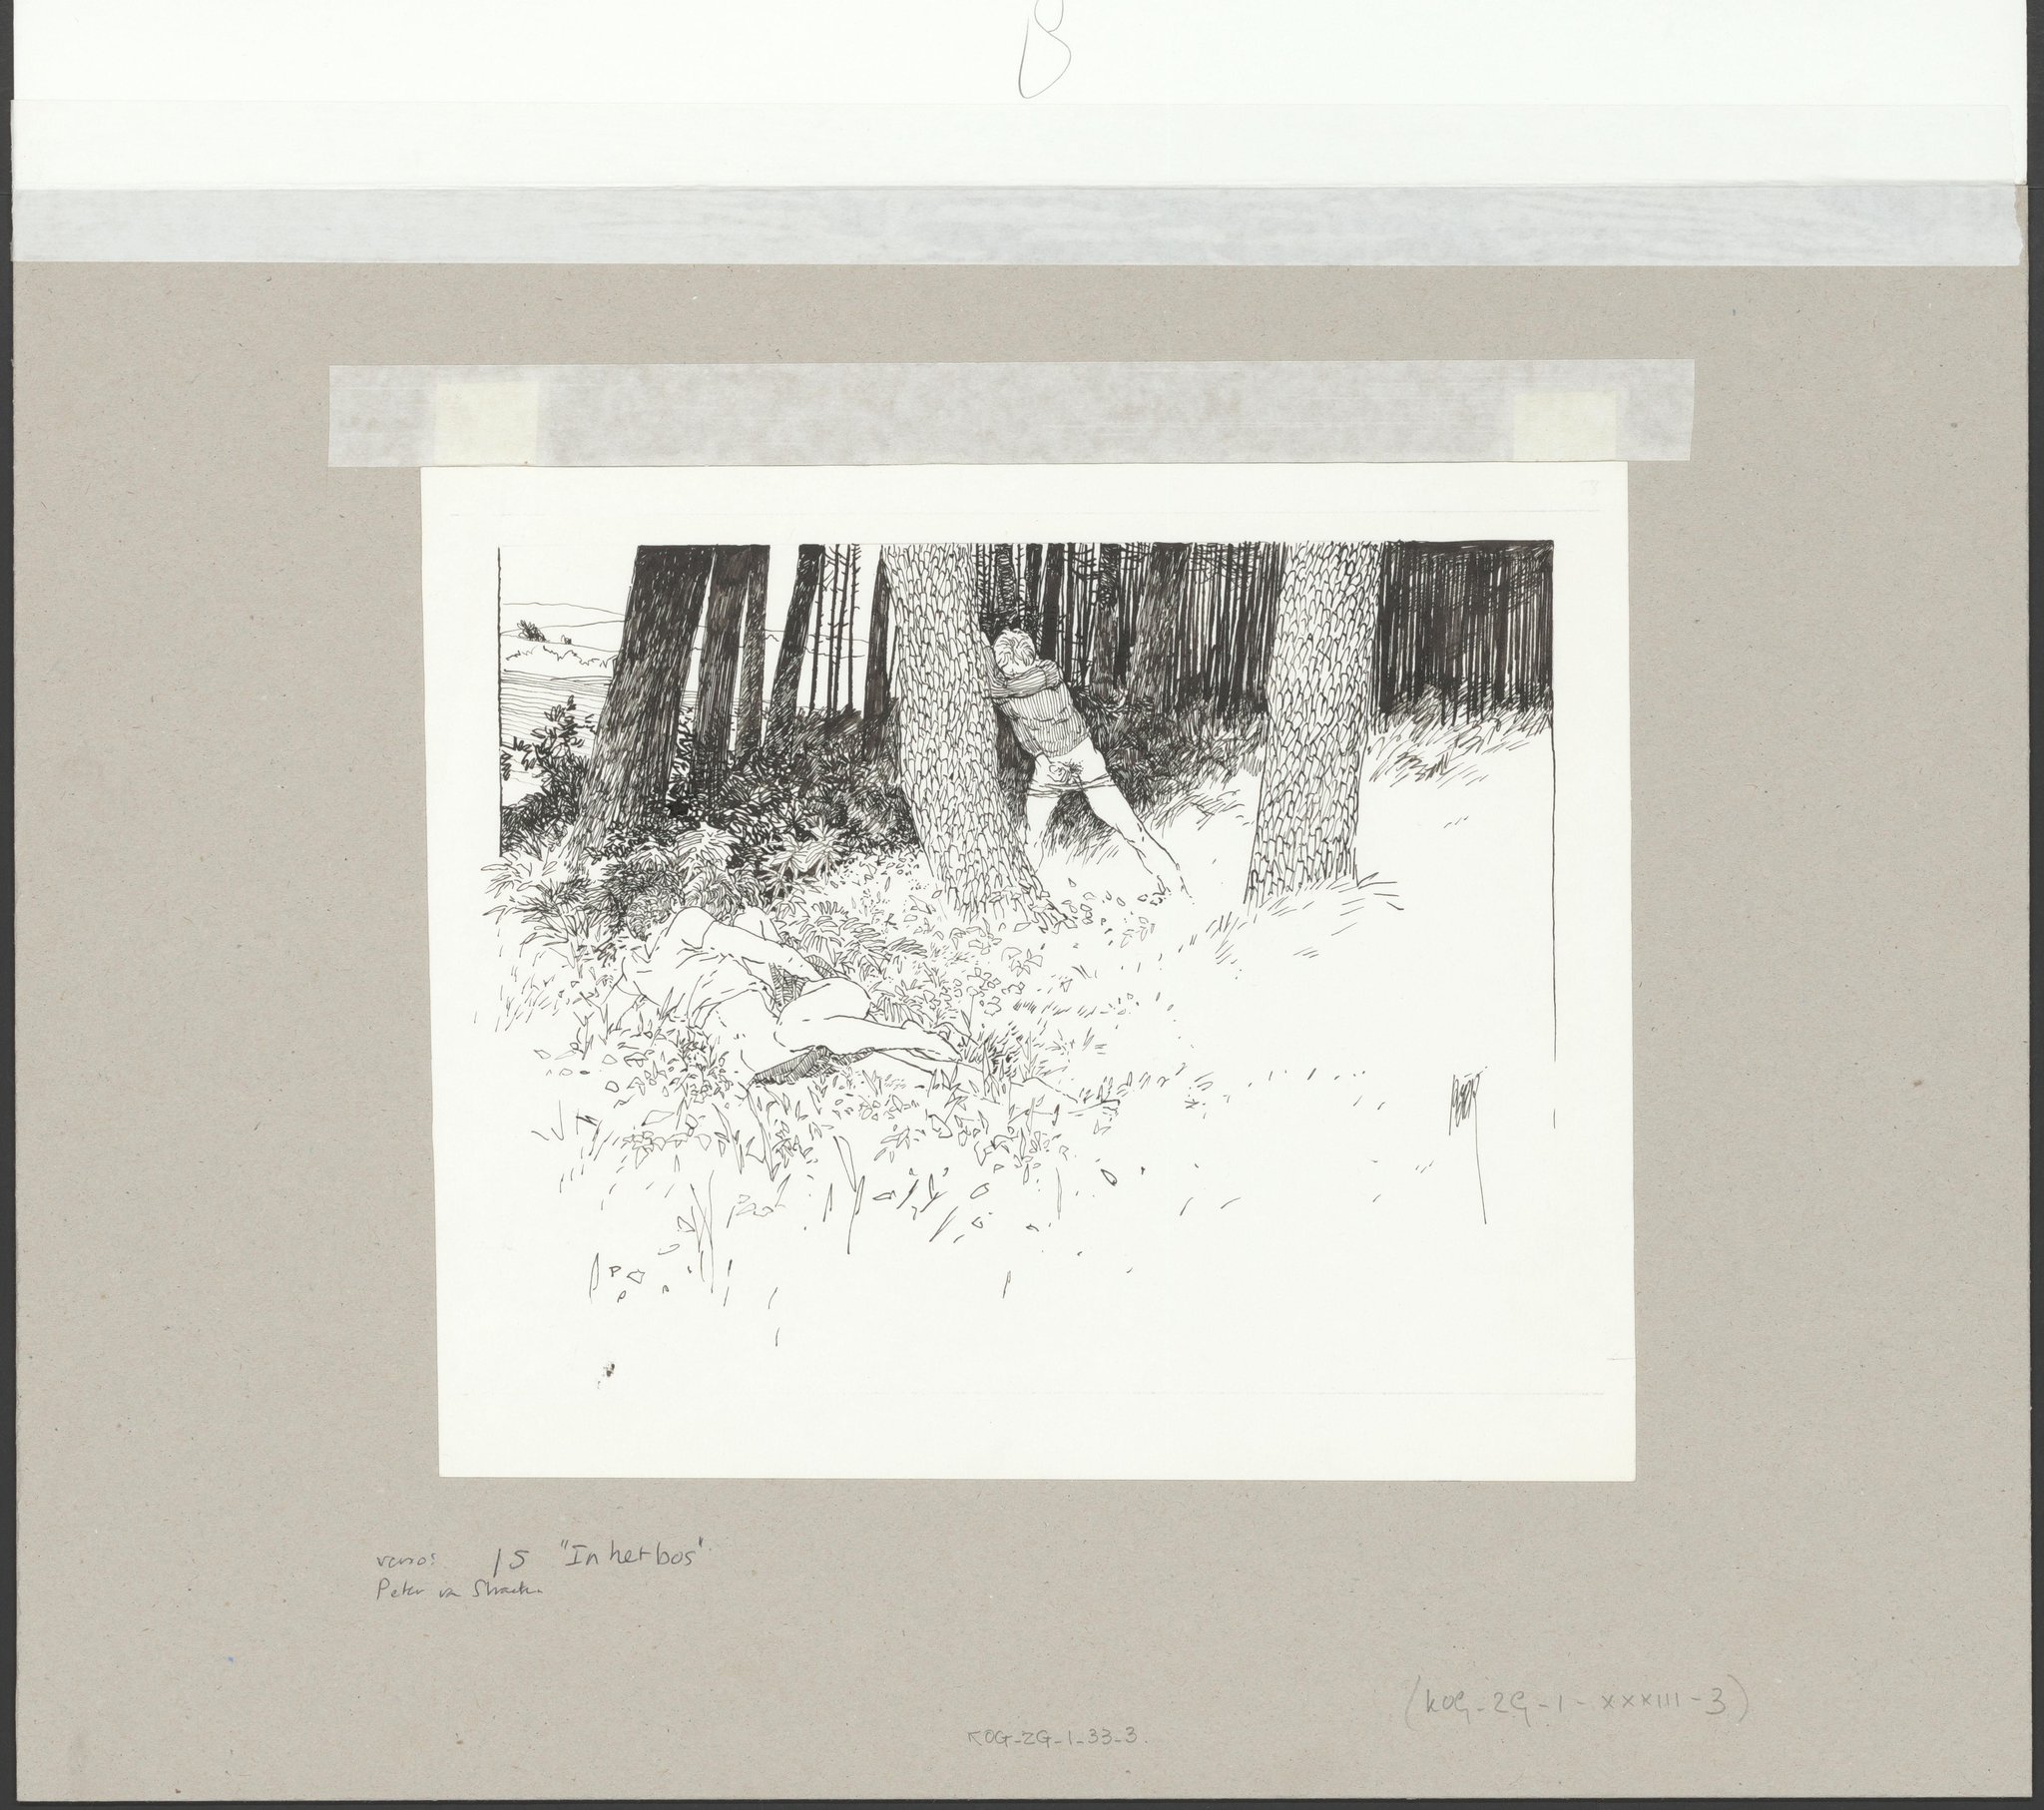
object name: drawing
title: Vrijend paar bij de bosrand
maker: peter van straaten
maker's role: draughtsman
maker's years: 1935-2016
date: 1945-2010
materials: ink, paper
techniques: pen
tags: man and woman cohabiting, forest, wood, masturbation, onanism, coitus, cohabiting, sexual intercourse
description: Vrijend paar bij de bosrand. Op de achtergrond een masturberende man die tegen een boom leunt. Op verso genummerd: 15.